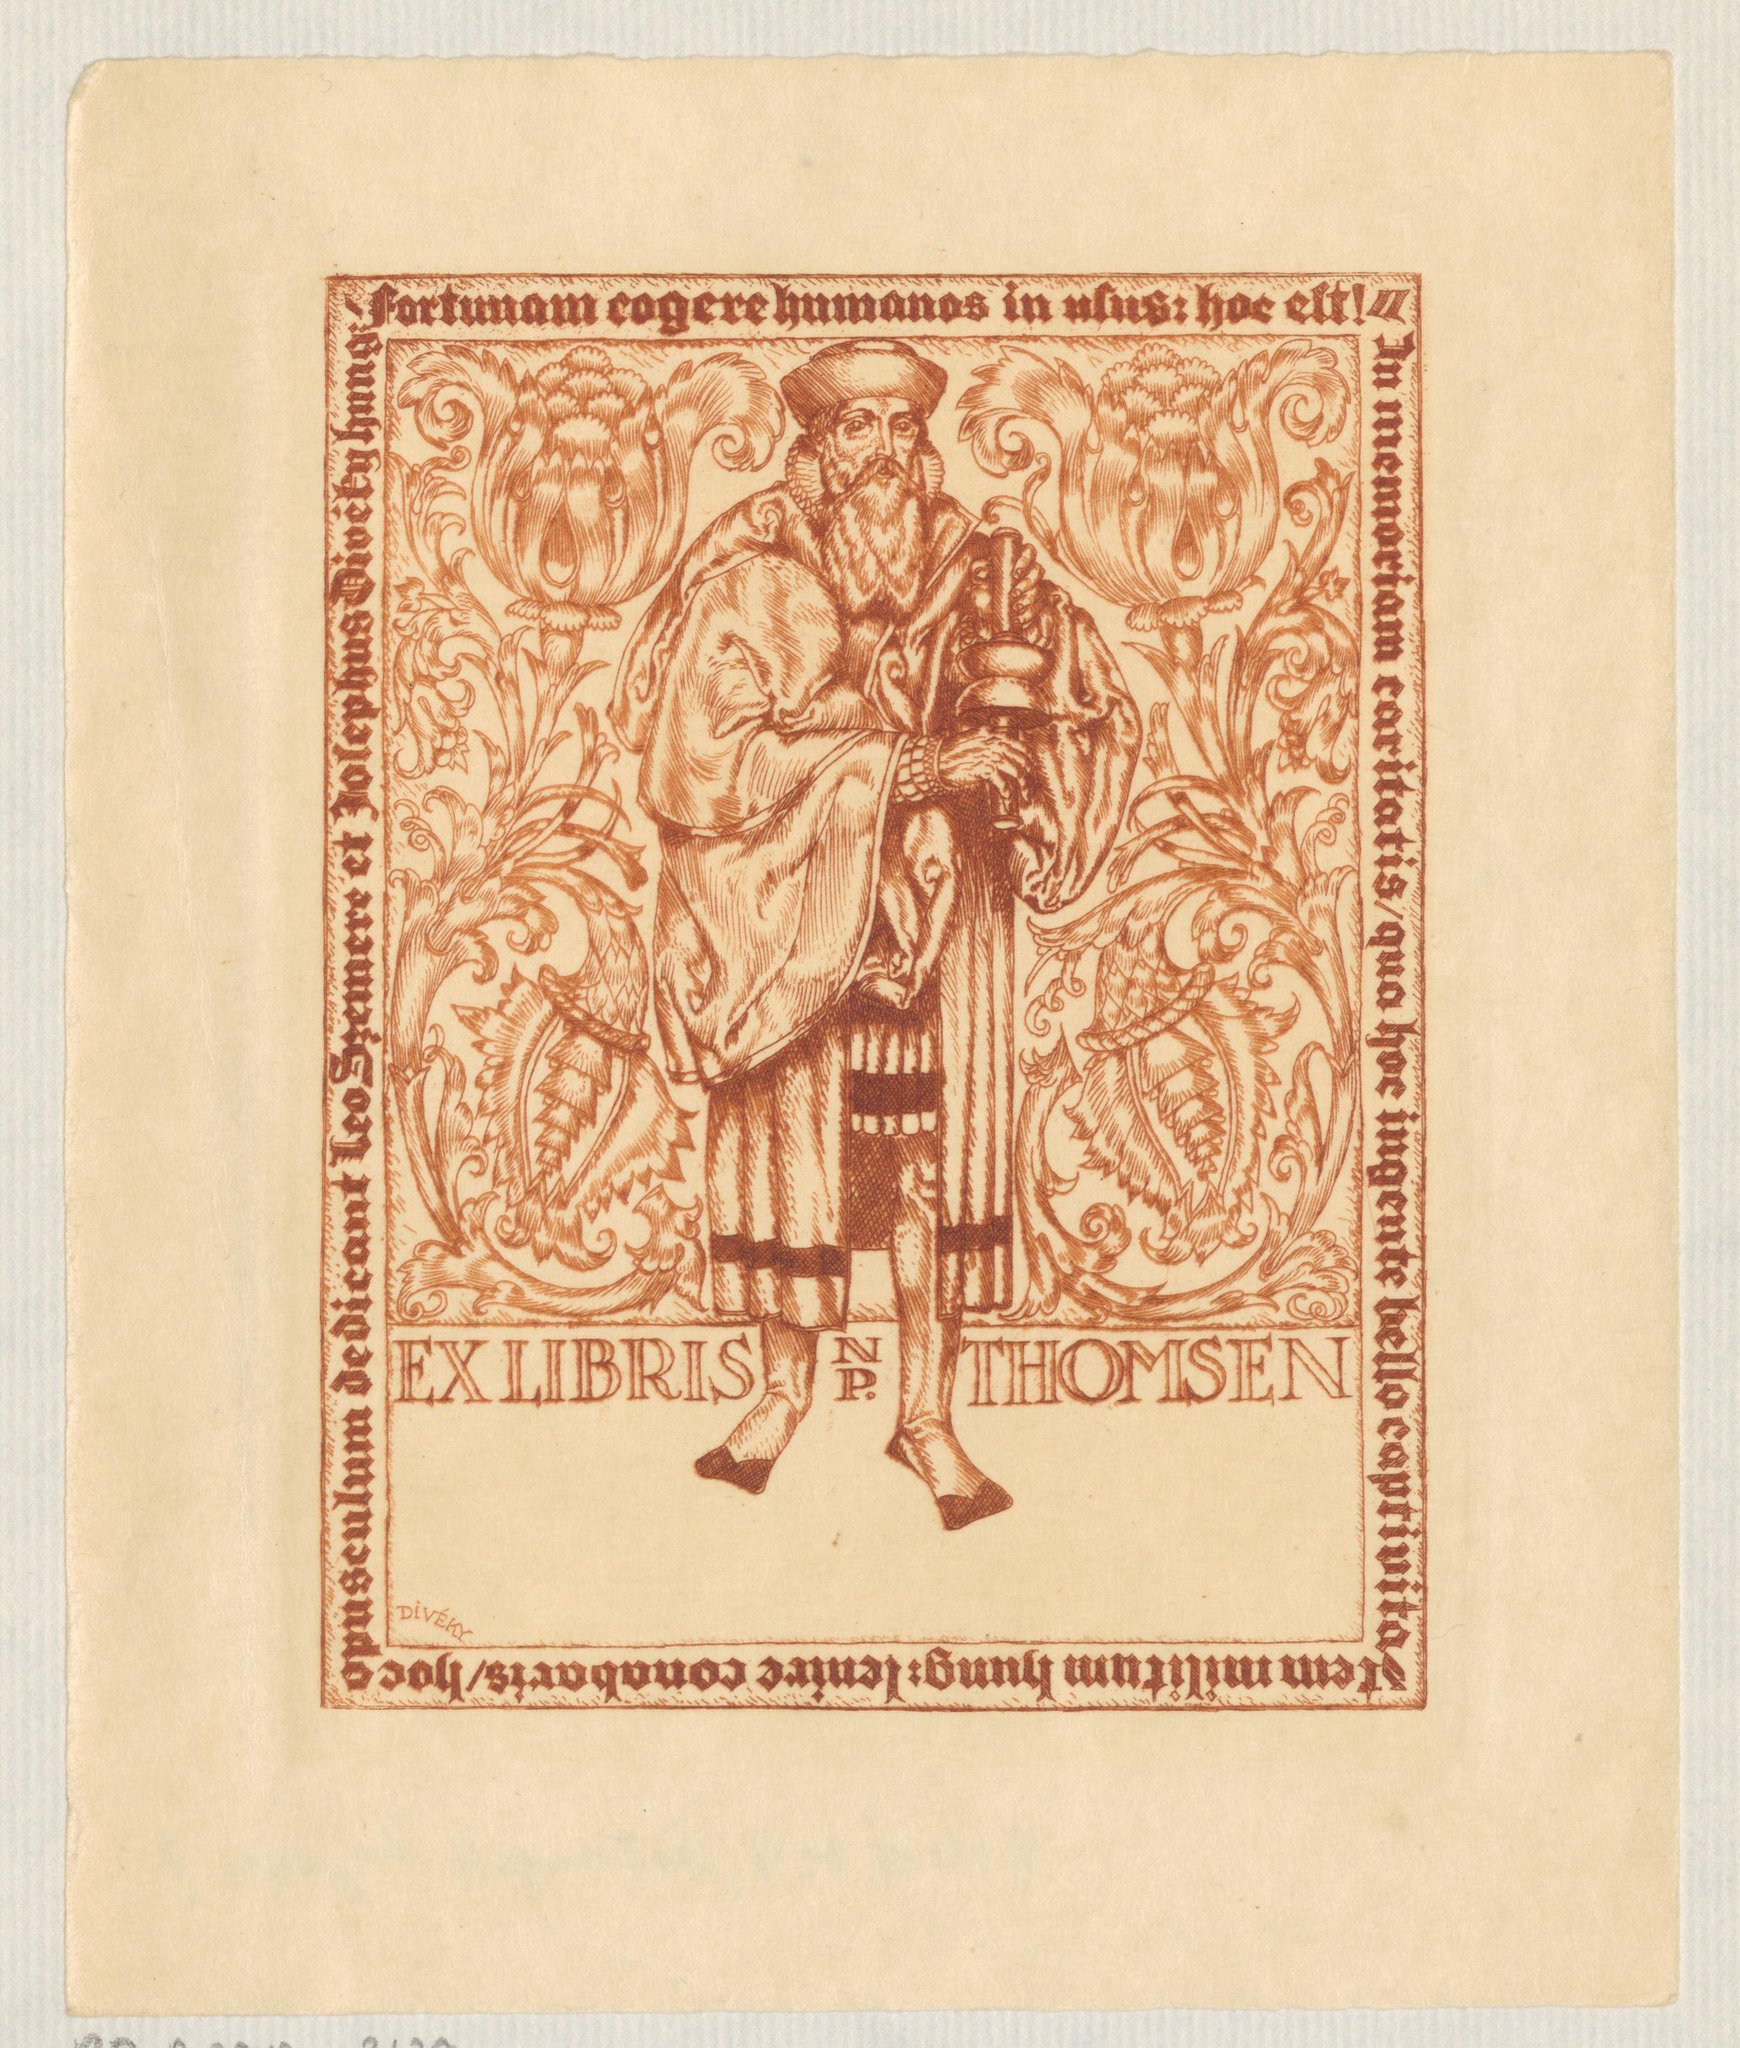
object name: bookplate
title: Ex libris van N.P. Thomsen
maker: józsef divéky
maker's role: print maker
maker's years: 1887-1951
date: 1897-1951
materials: paper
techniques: etching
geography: hungary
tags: printer, johannes gutenberg, floral interlace ~ ornament, tools, implements of graphic artist, historical costume